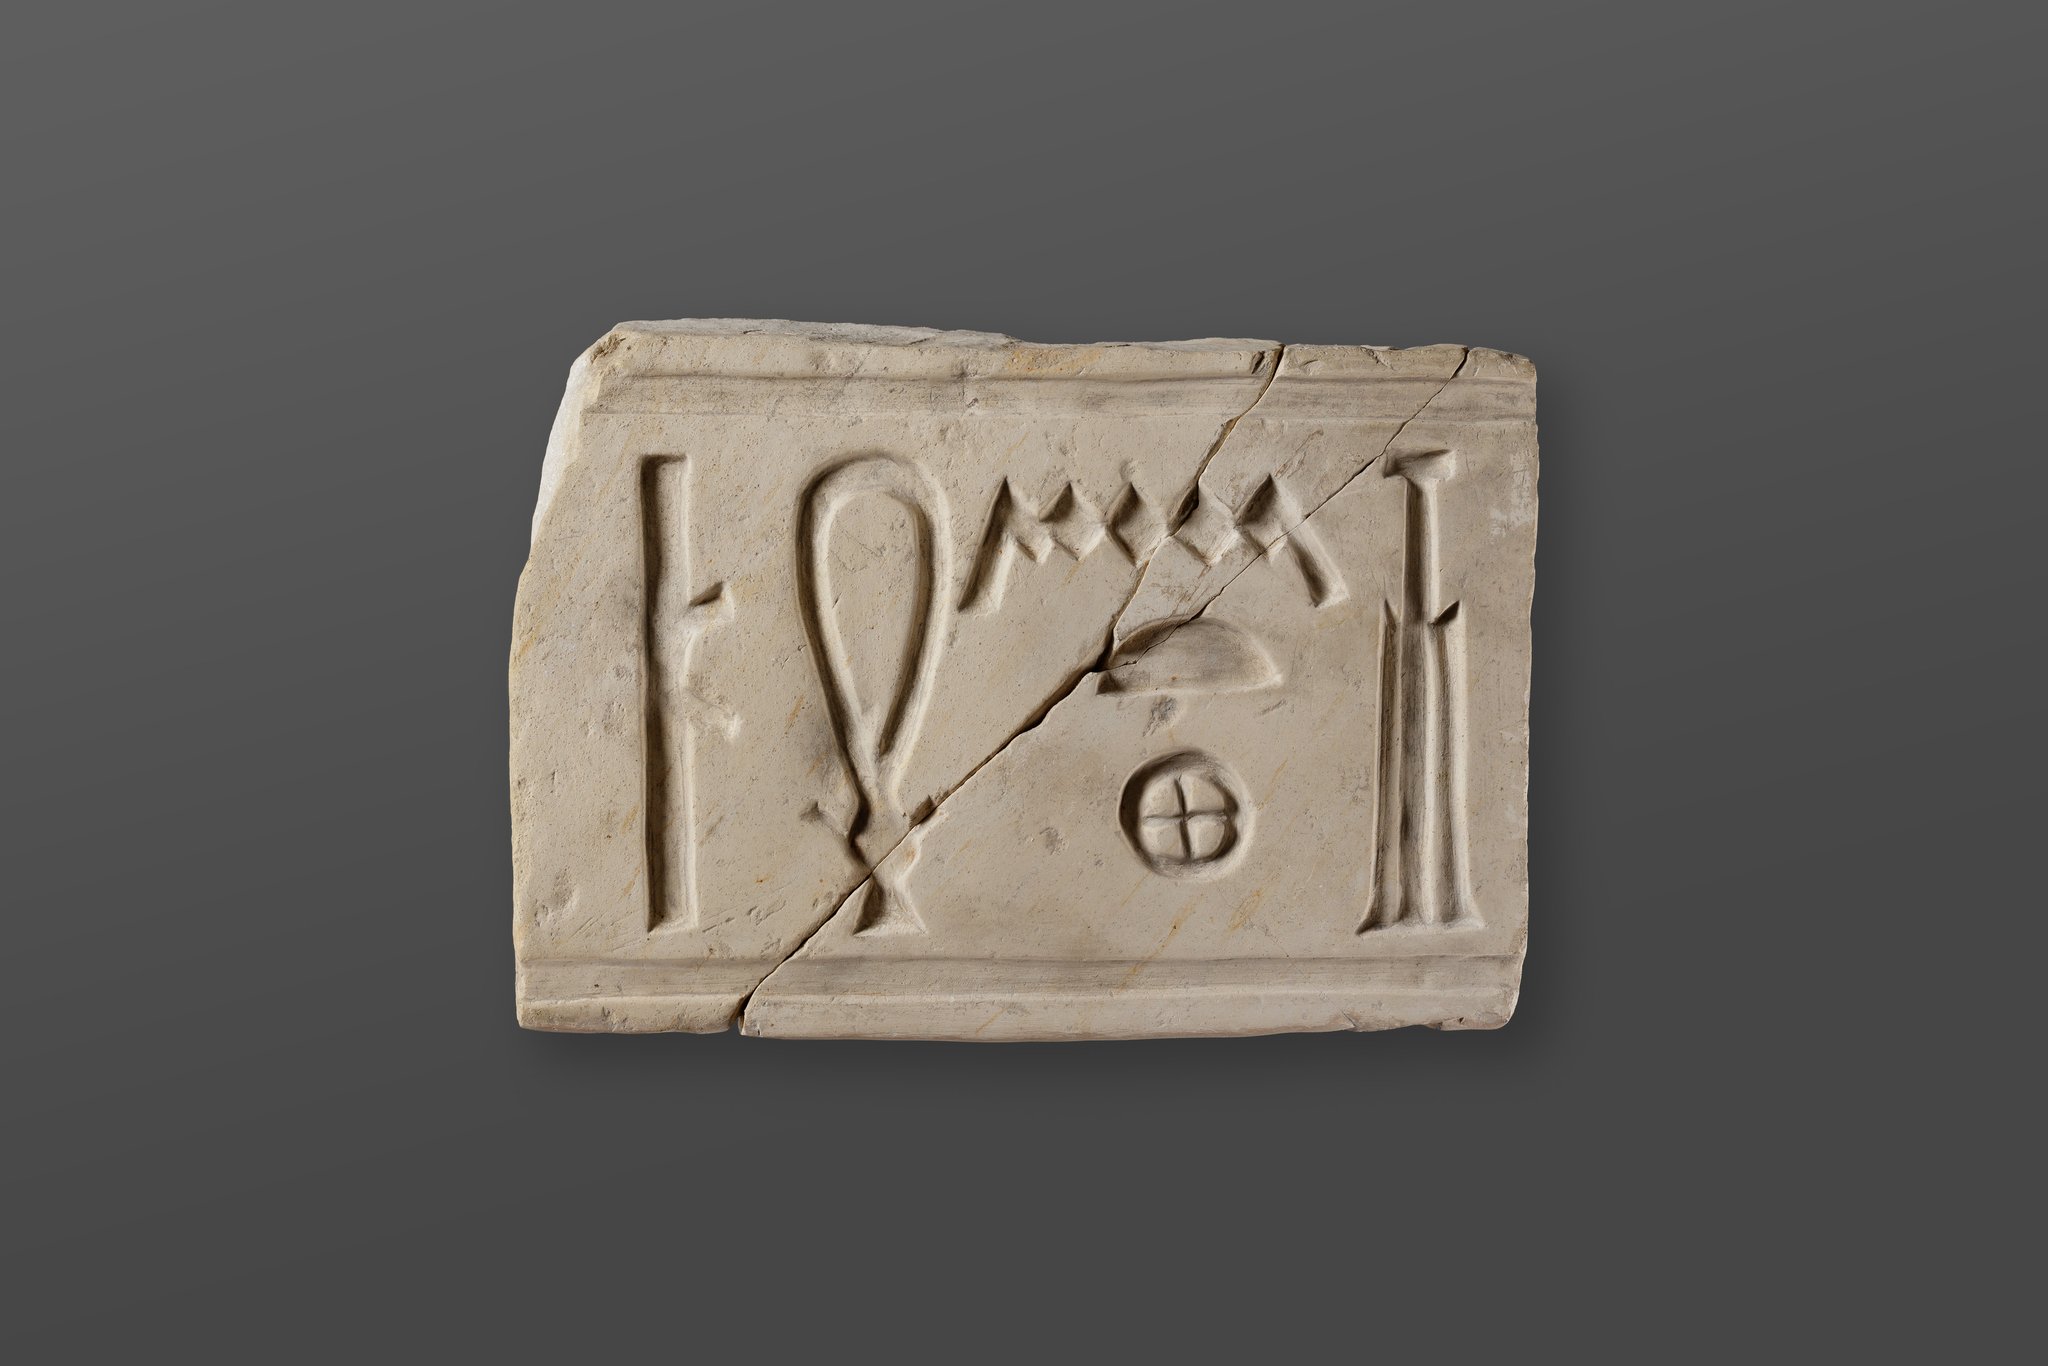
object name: relief fragment, tomb of mereri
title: Frieze from the tomb of Mereri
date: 2100-2030 BCE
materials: limestone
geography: egypt